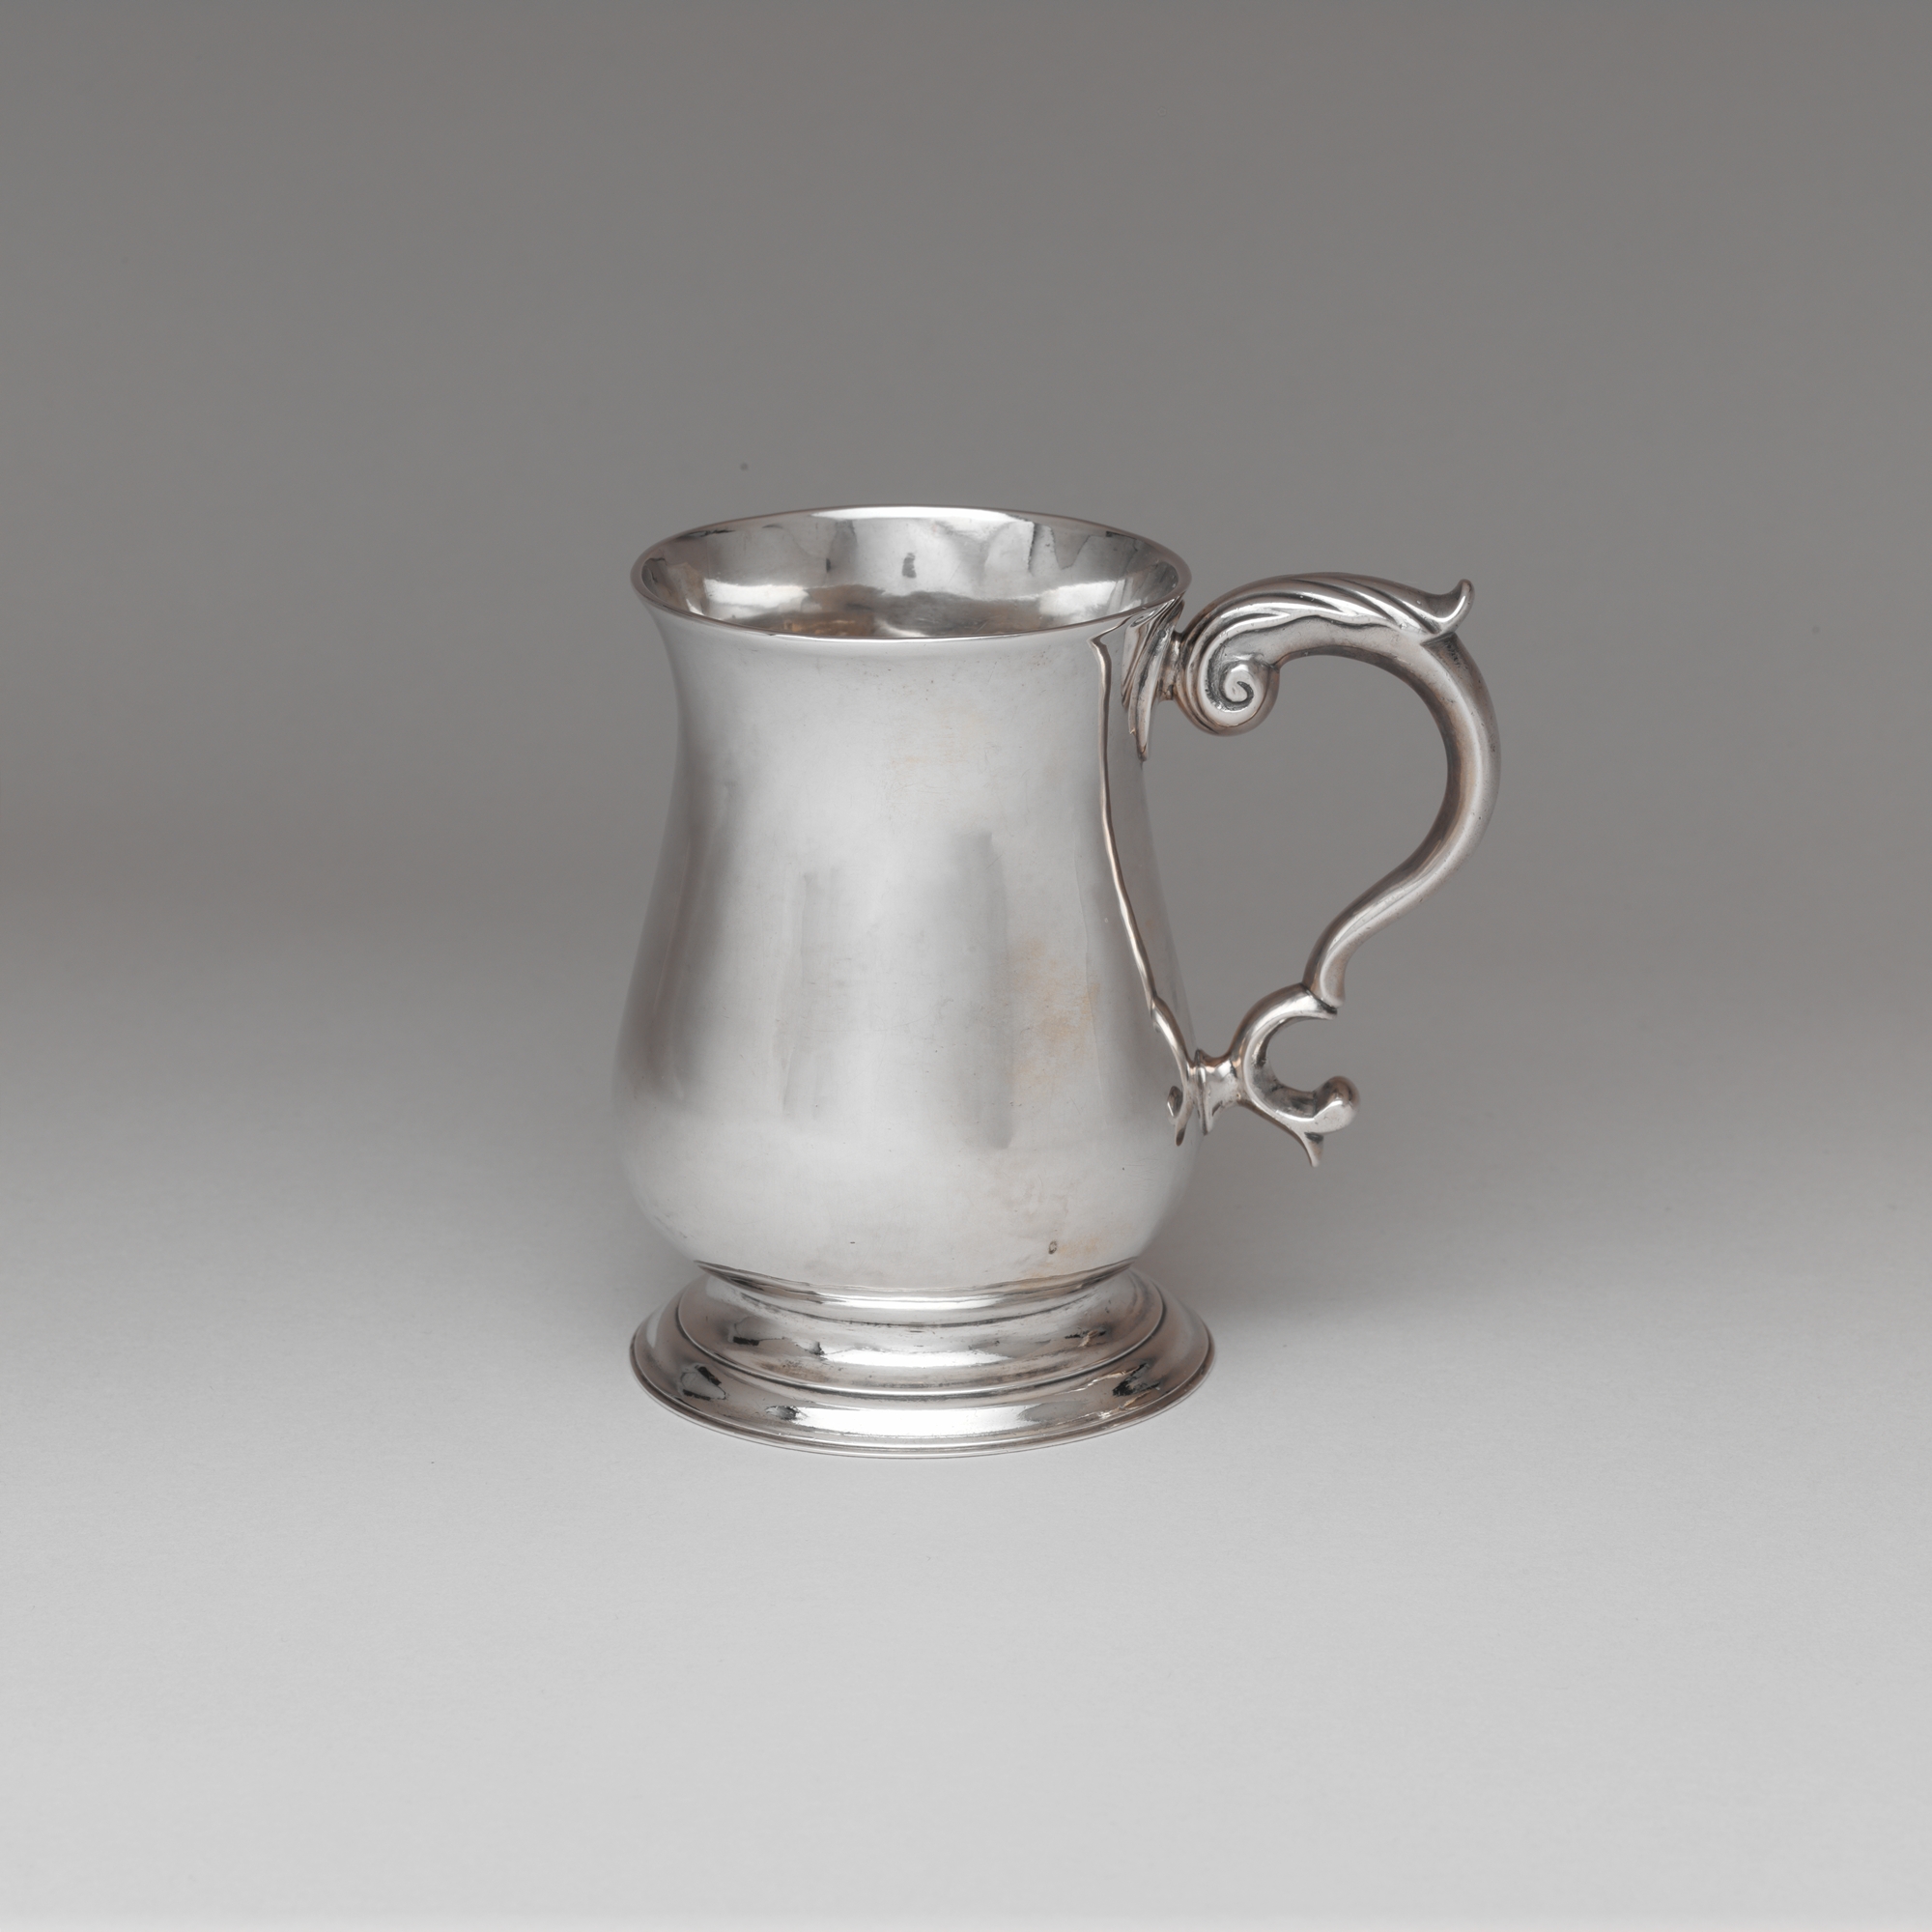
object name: cann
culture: american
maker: joseph richardson jr.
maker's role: maker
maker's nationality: american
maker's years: 1752-1831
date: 1785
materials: silver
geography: united states